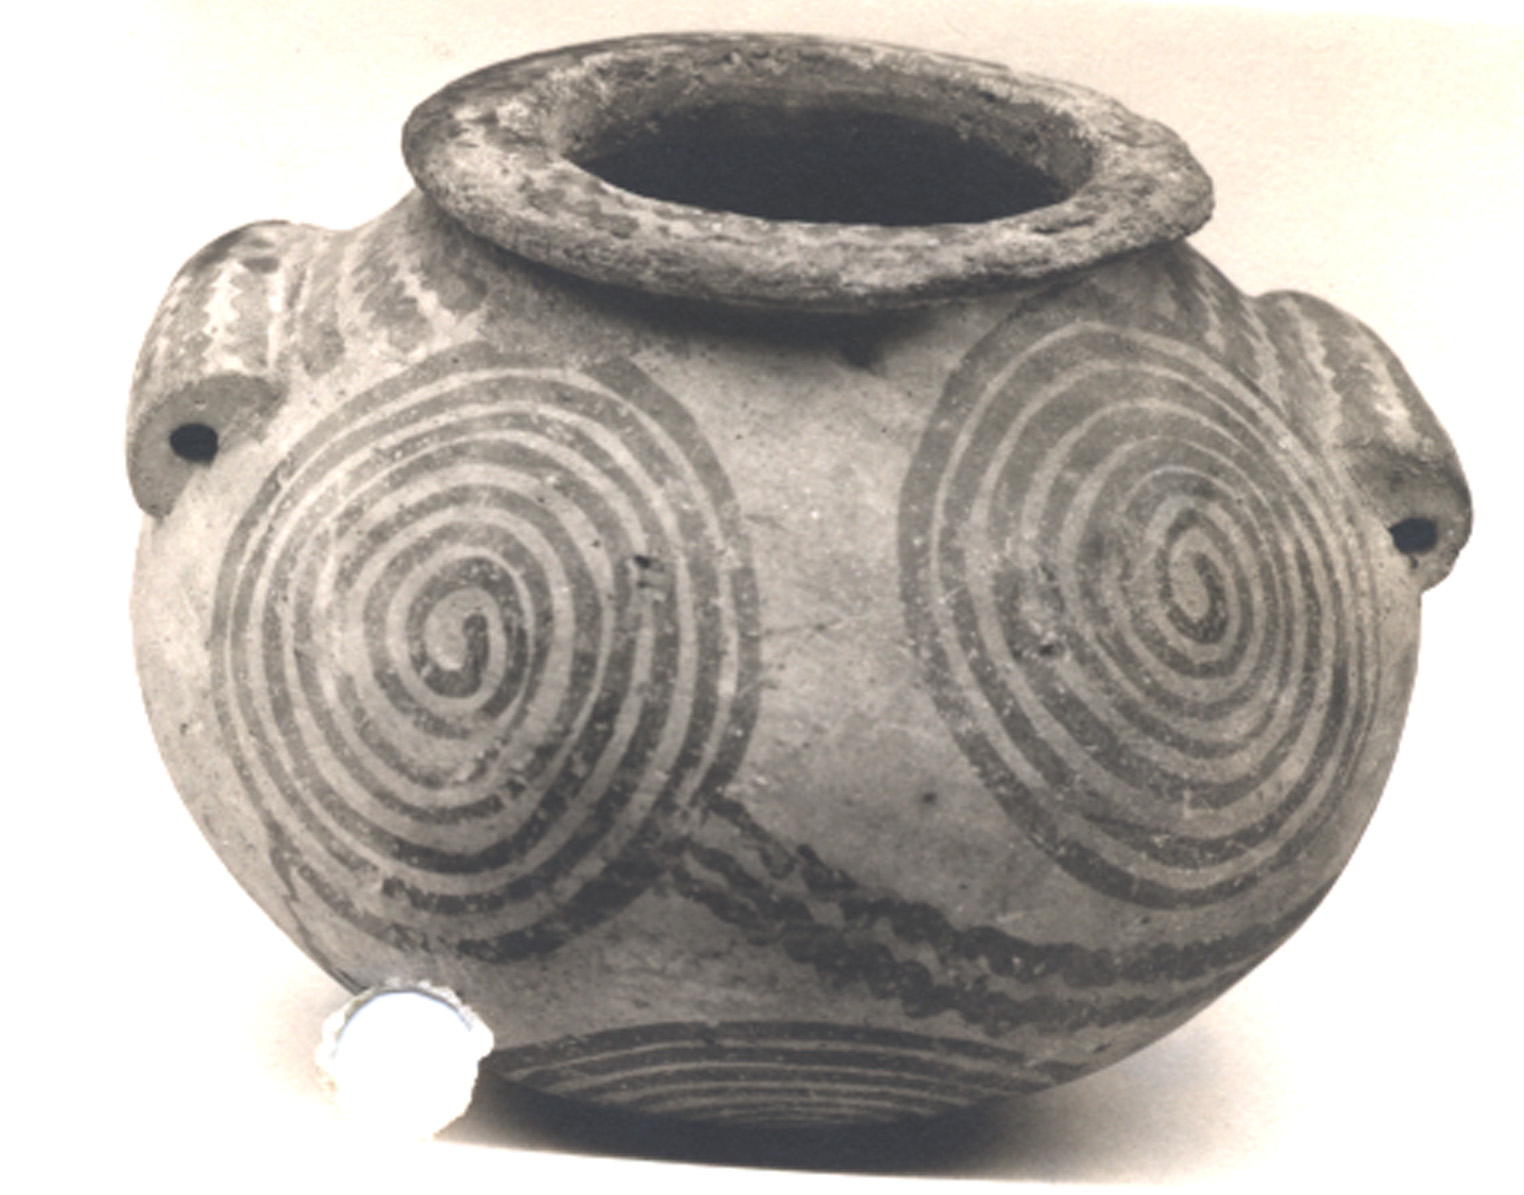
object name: jar, two handled, spiral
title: Jar with two handles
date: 3850-2960 BCE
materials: paint, pottery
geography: egypt